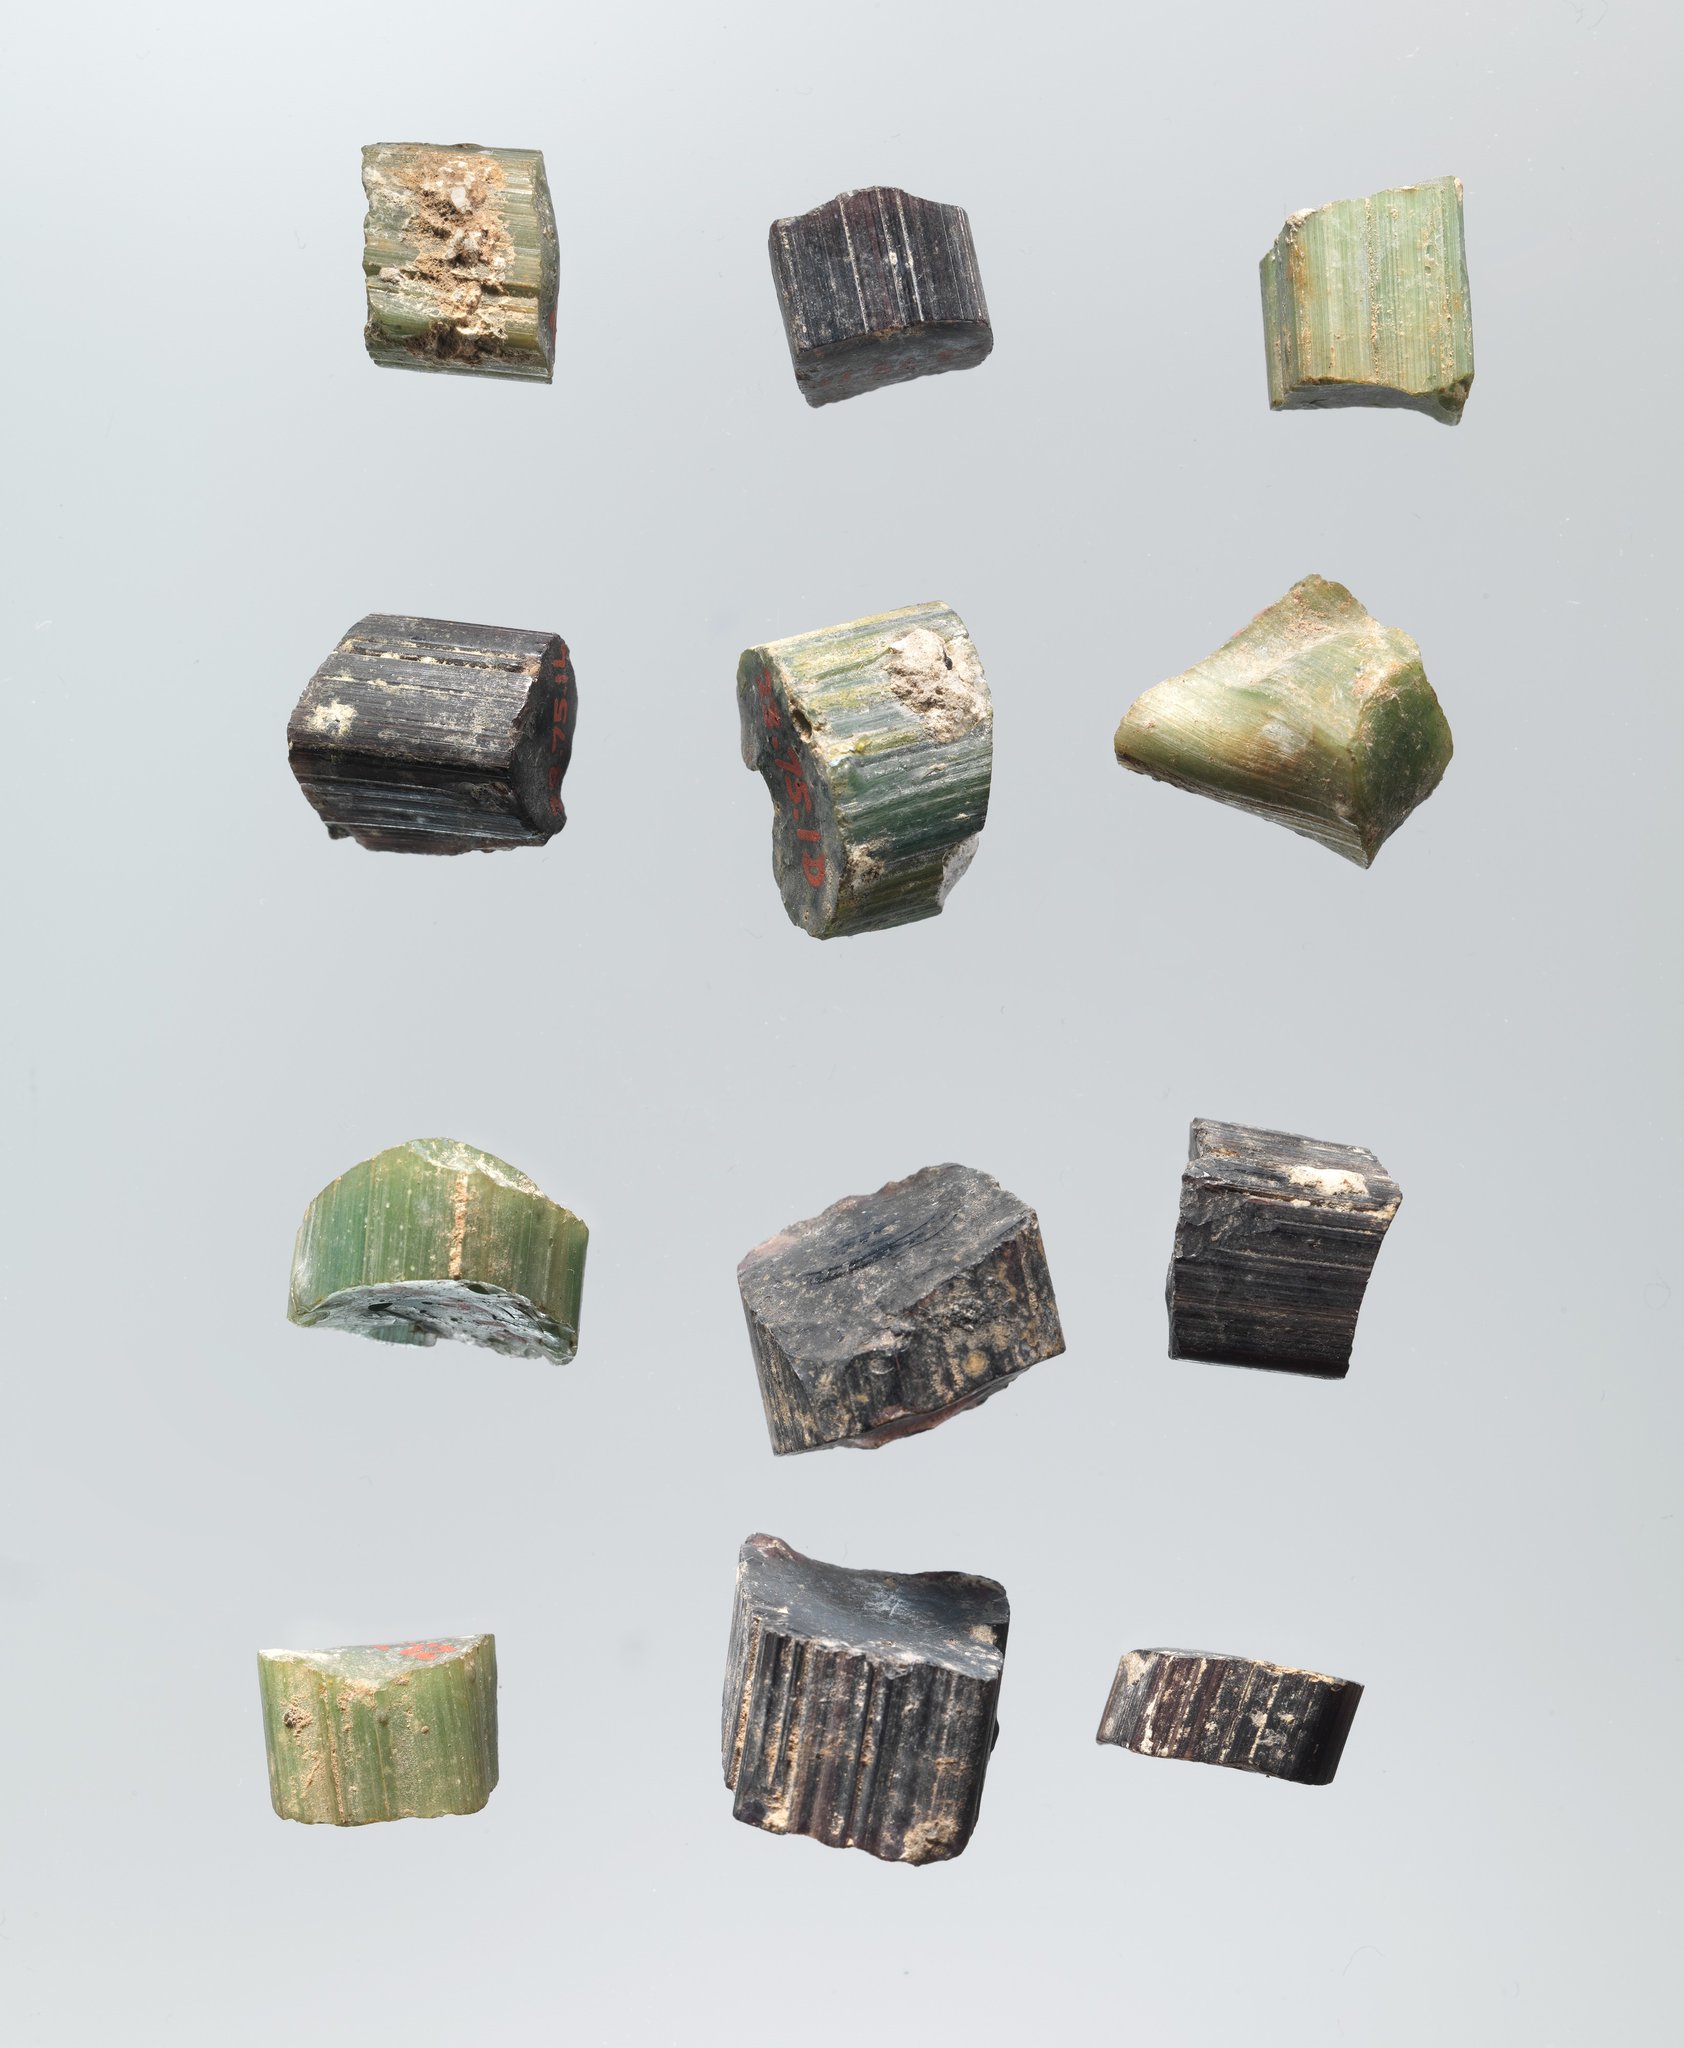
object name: glass fragment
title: Mosaic Tesserae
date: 801-900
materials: glass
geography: iraq